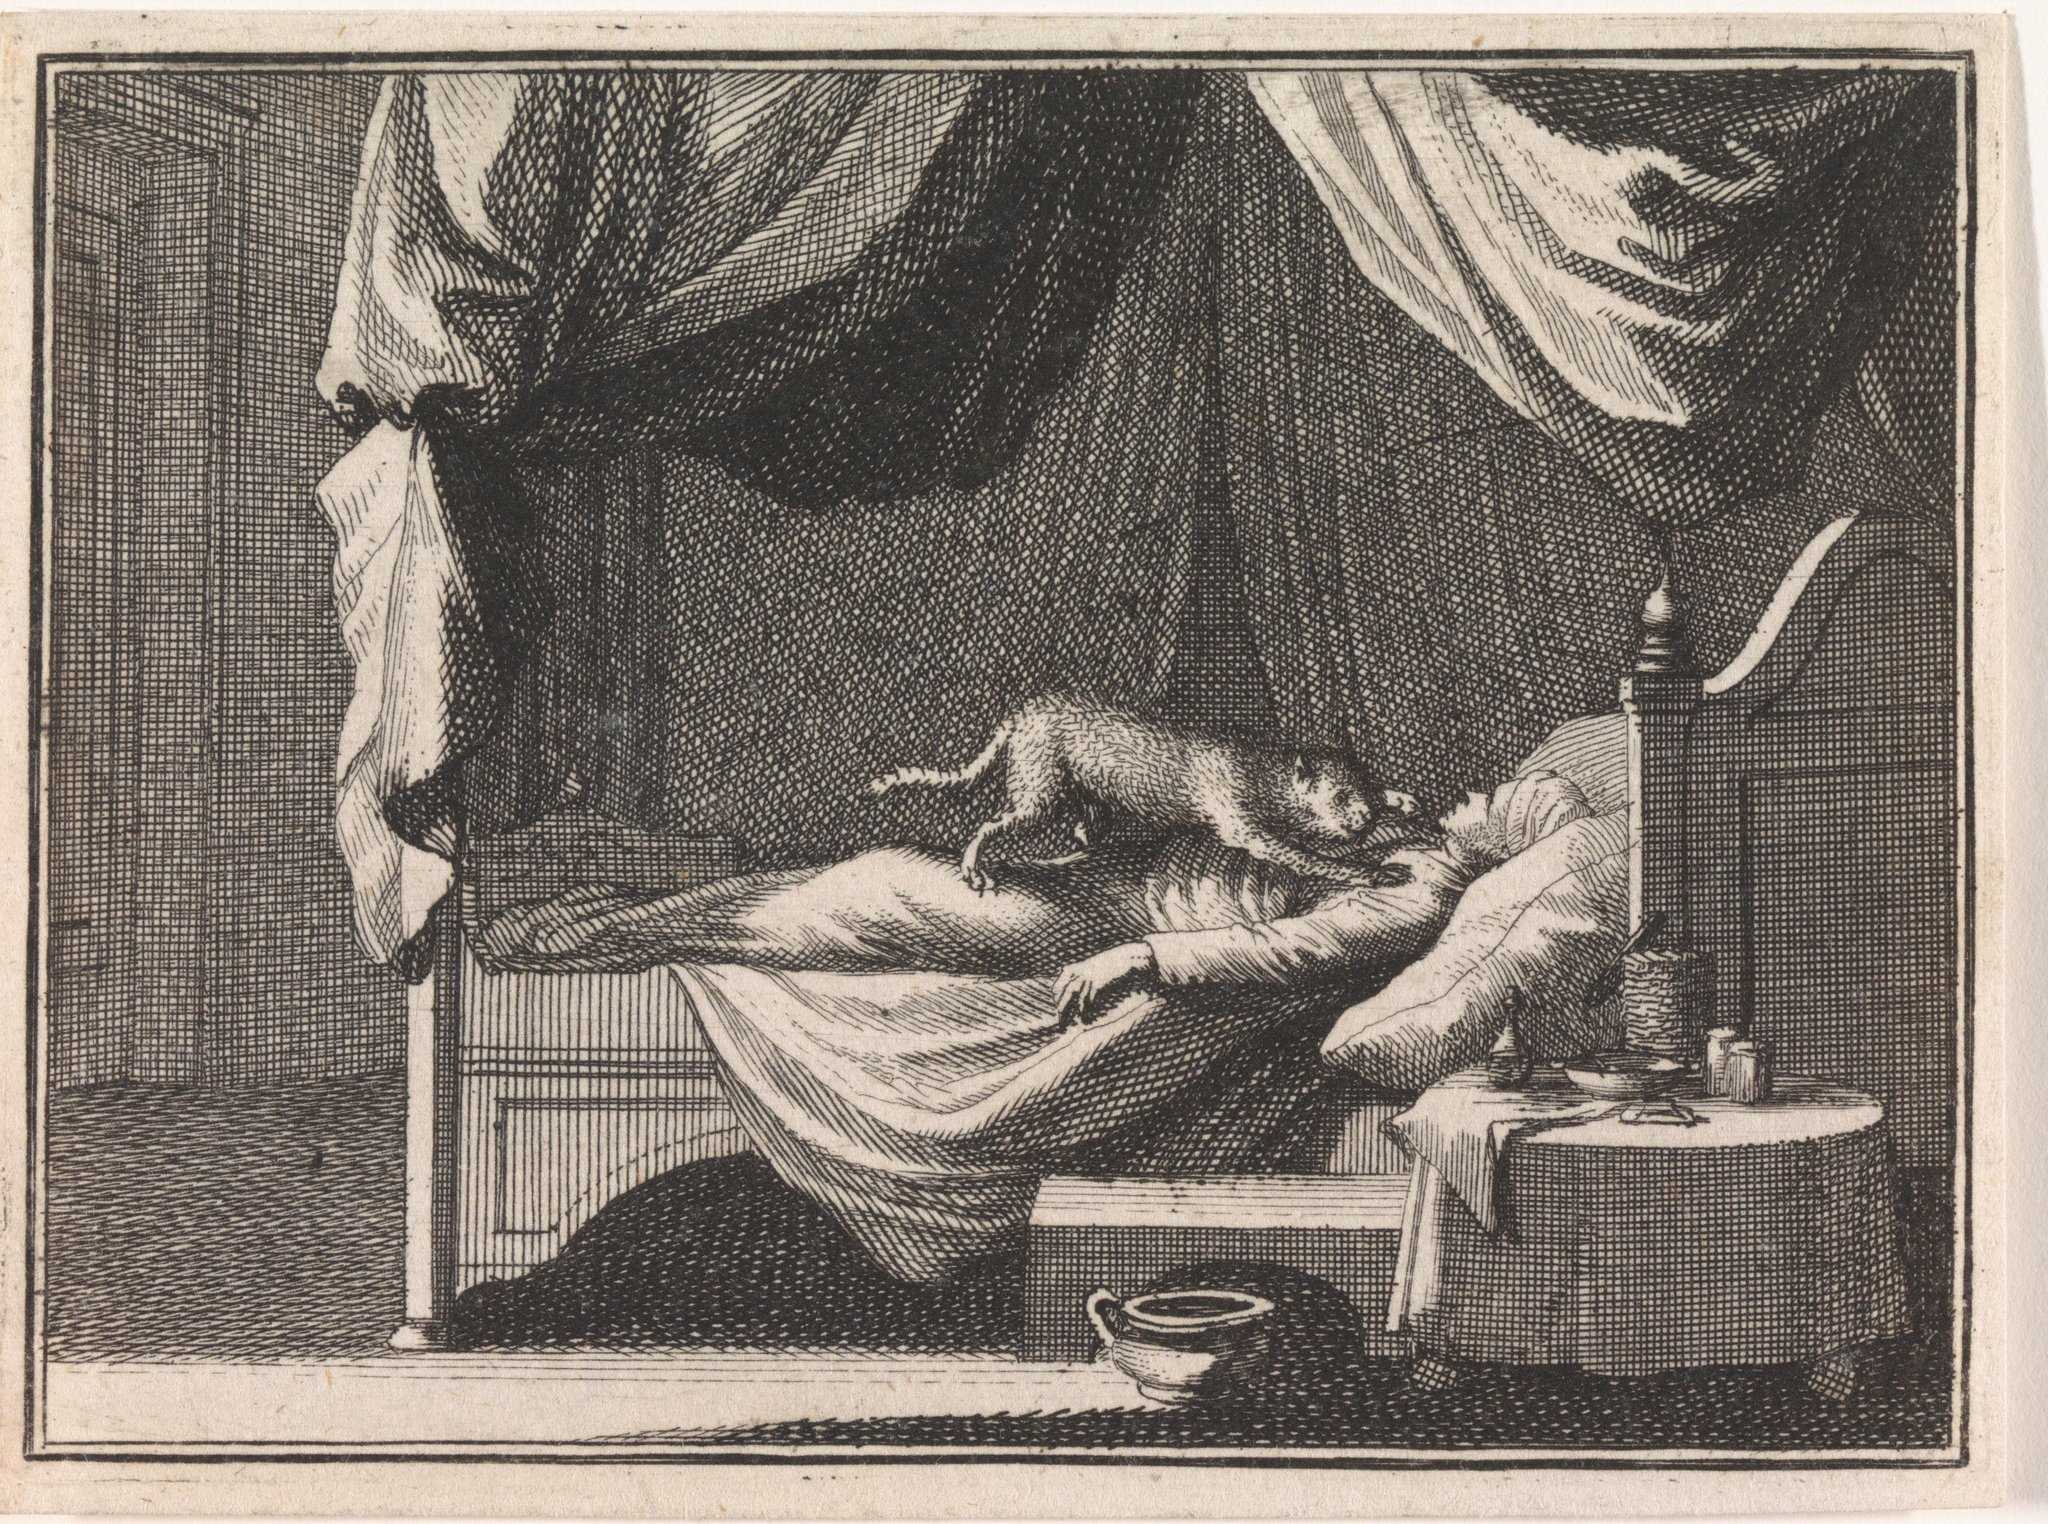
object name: book illustration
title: Slapende ketter wordt aangevallen door een kat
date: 1710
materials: paper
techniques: etching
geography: nuremberg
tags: heretic, cat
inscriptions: collector's mark: Lugt 240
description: Illustratie uit: Abraham a Sancta Clara. Heilsames Gemisch Gemasch, das ist: Allerley seltsame und verwunderliche Geschichten (...). Neurenberg: Christoph Weigel, 1710, p. 81.